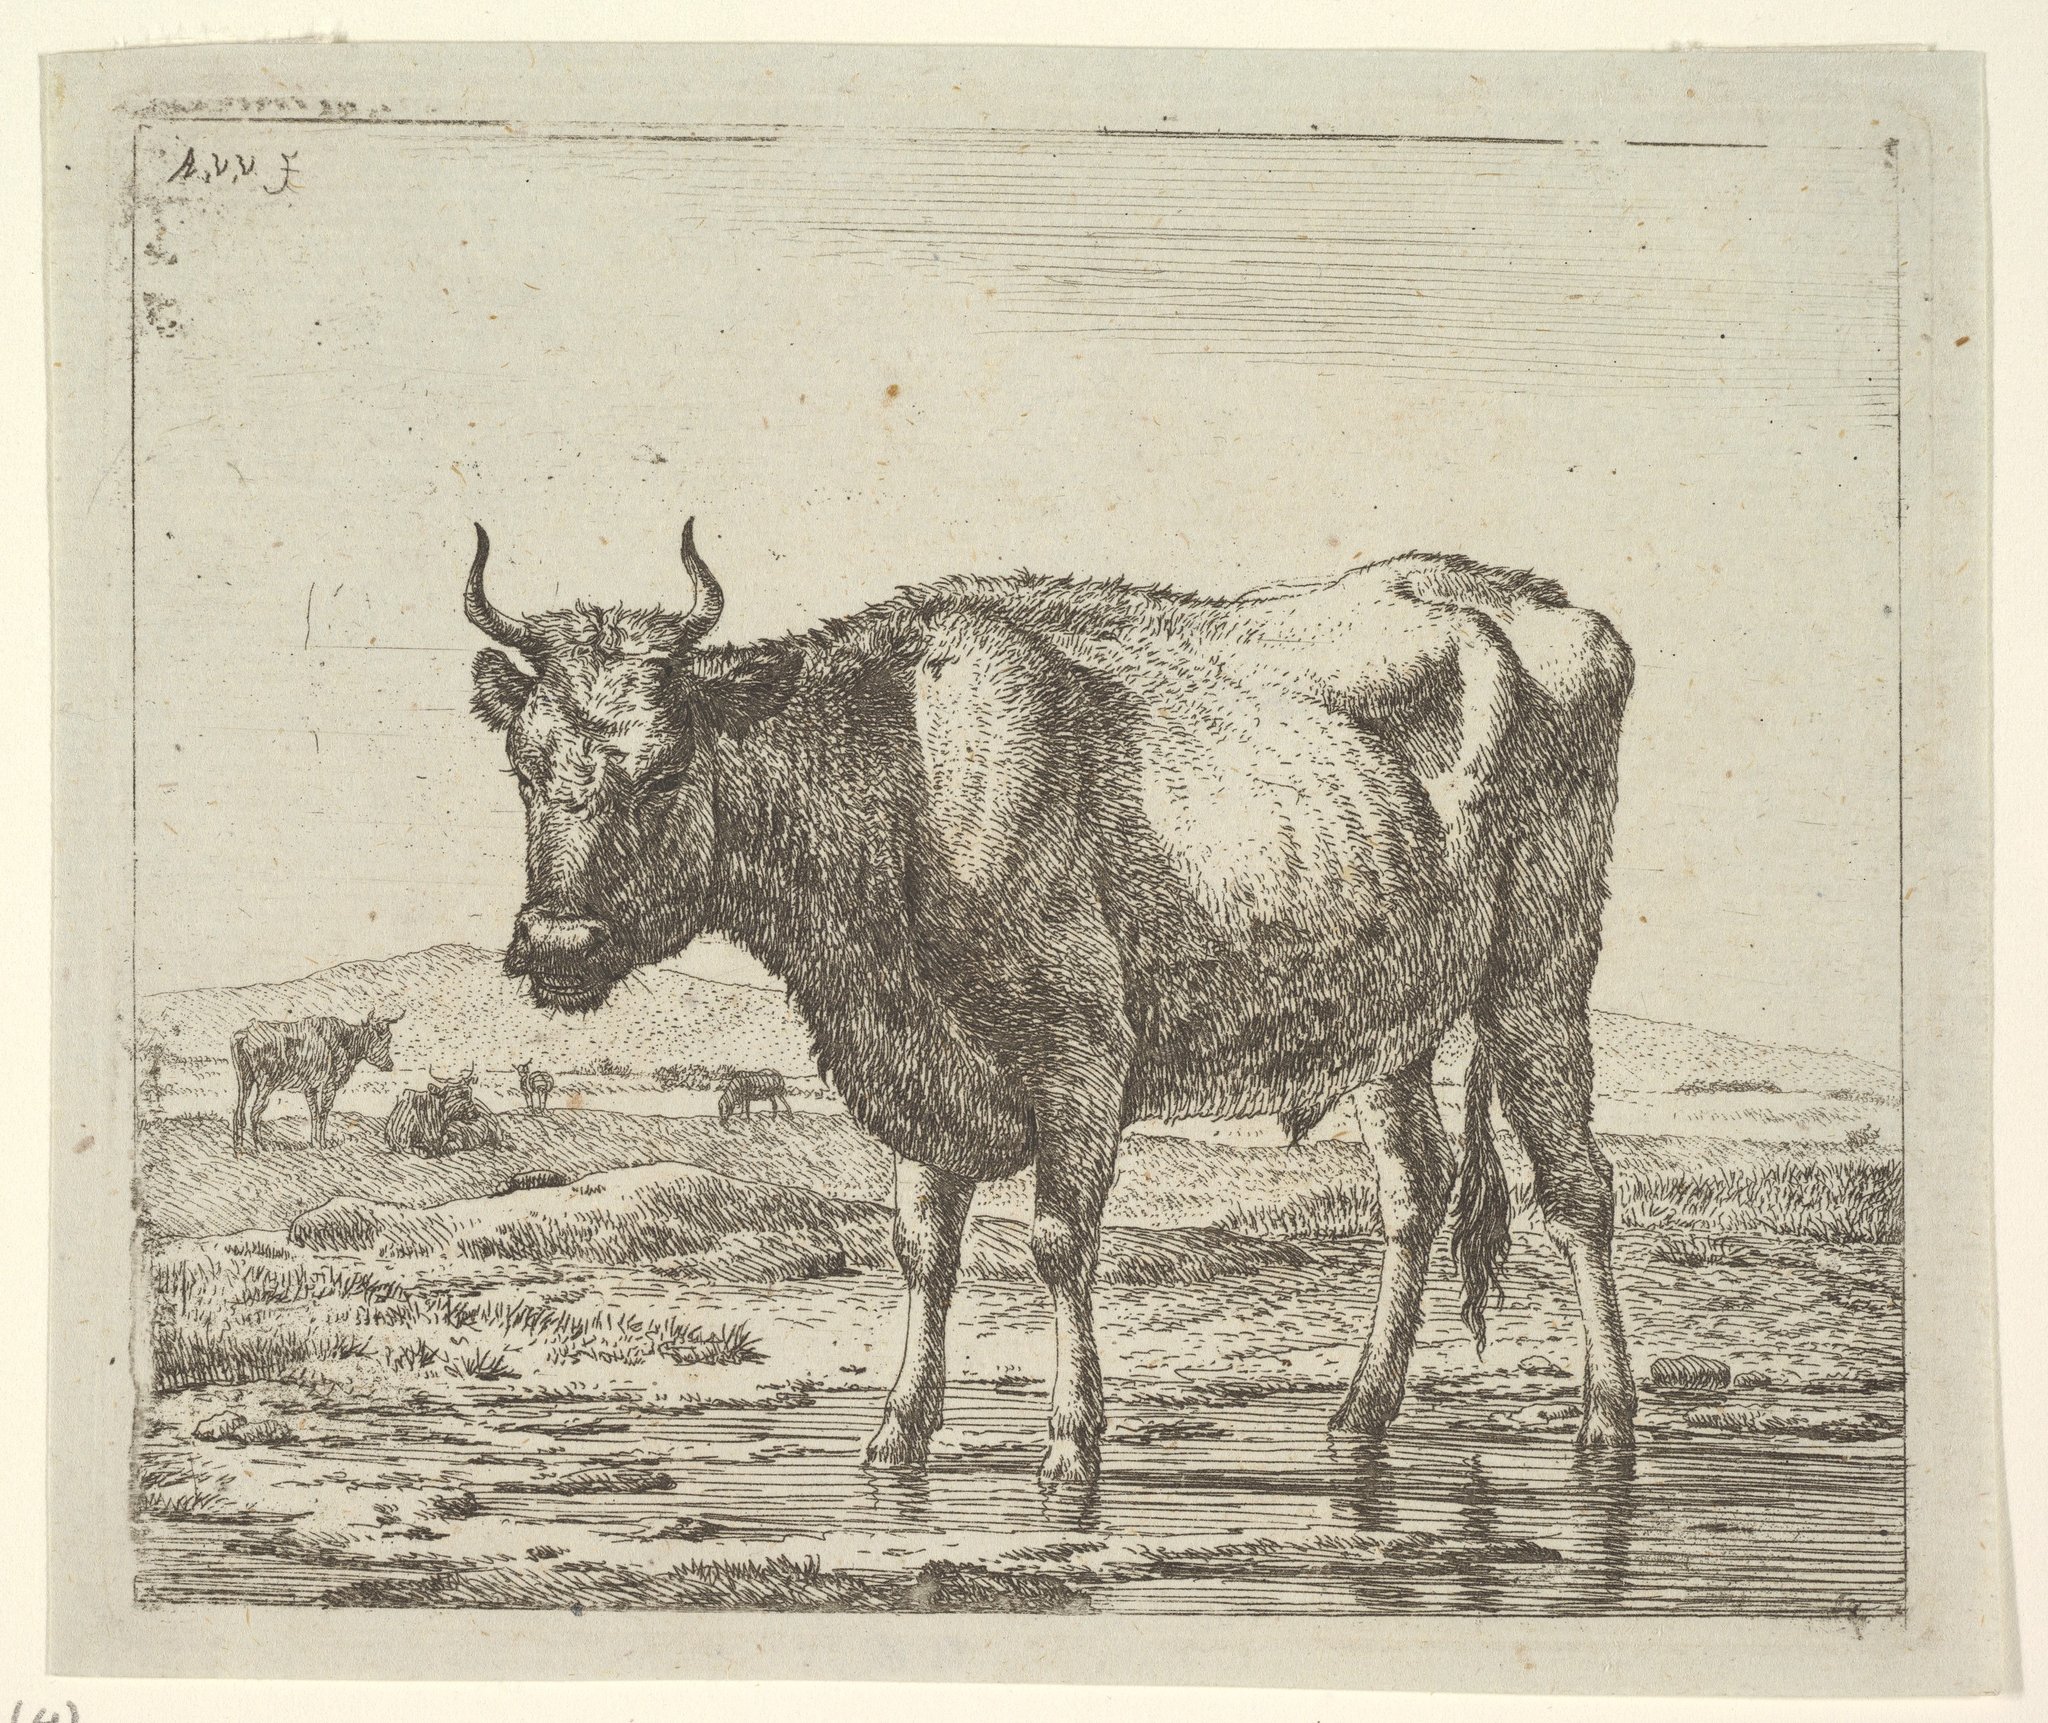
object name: print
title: Bull Standing in Water, plate 6 from "Different Animals"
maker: adriaen van de velde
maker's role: artist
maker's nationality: dutch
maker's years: 1636-1672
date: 1650-1672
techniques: etching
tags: bulls